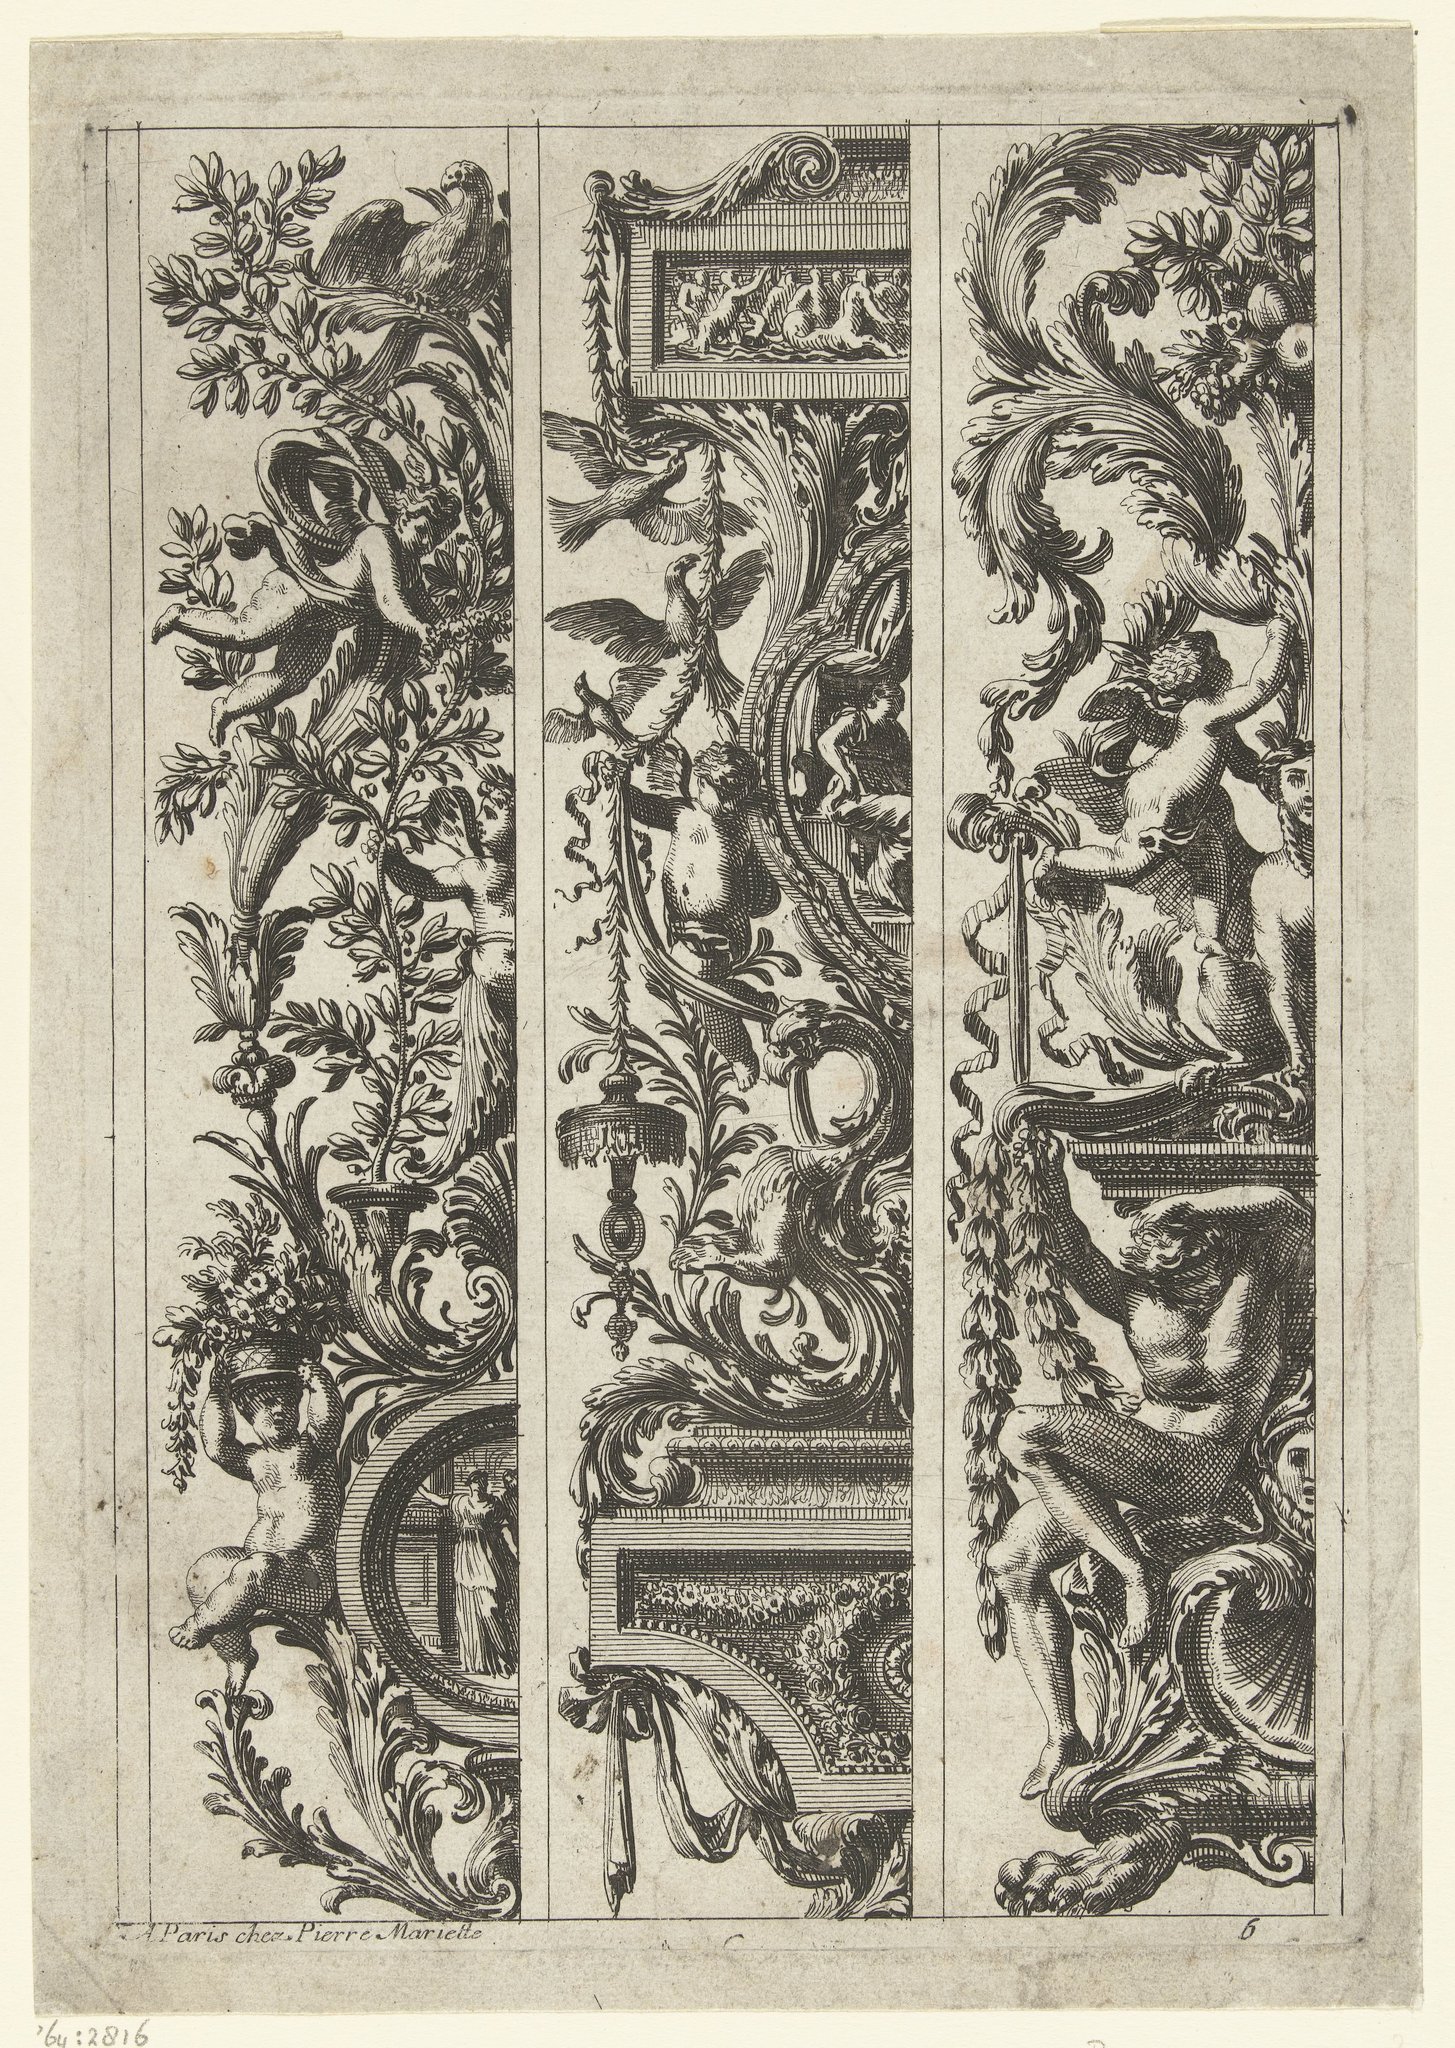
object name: ornament print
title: Grotesques et moresques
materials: paper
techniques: etching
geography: france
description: Van de panelen wordt alleen de linkerkant getoond en de composities zijn geïnspireerd op die van een kandelaber.